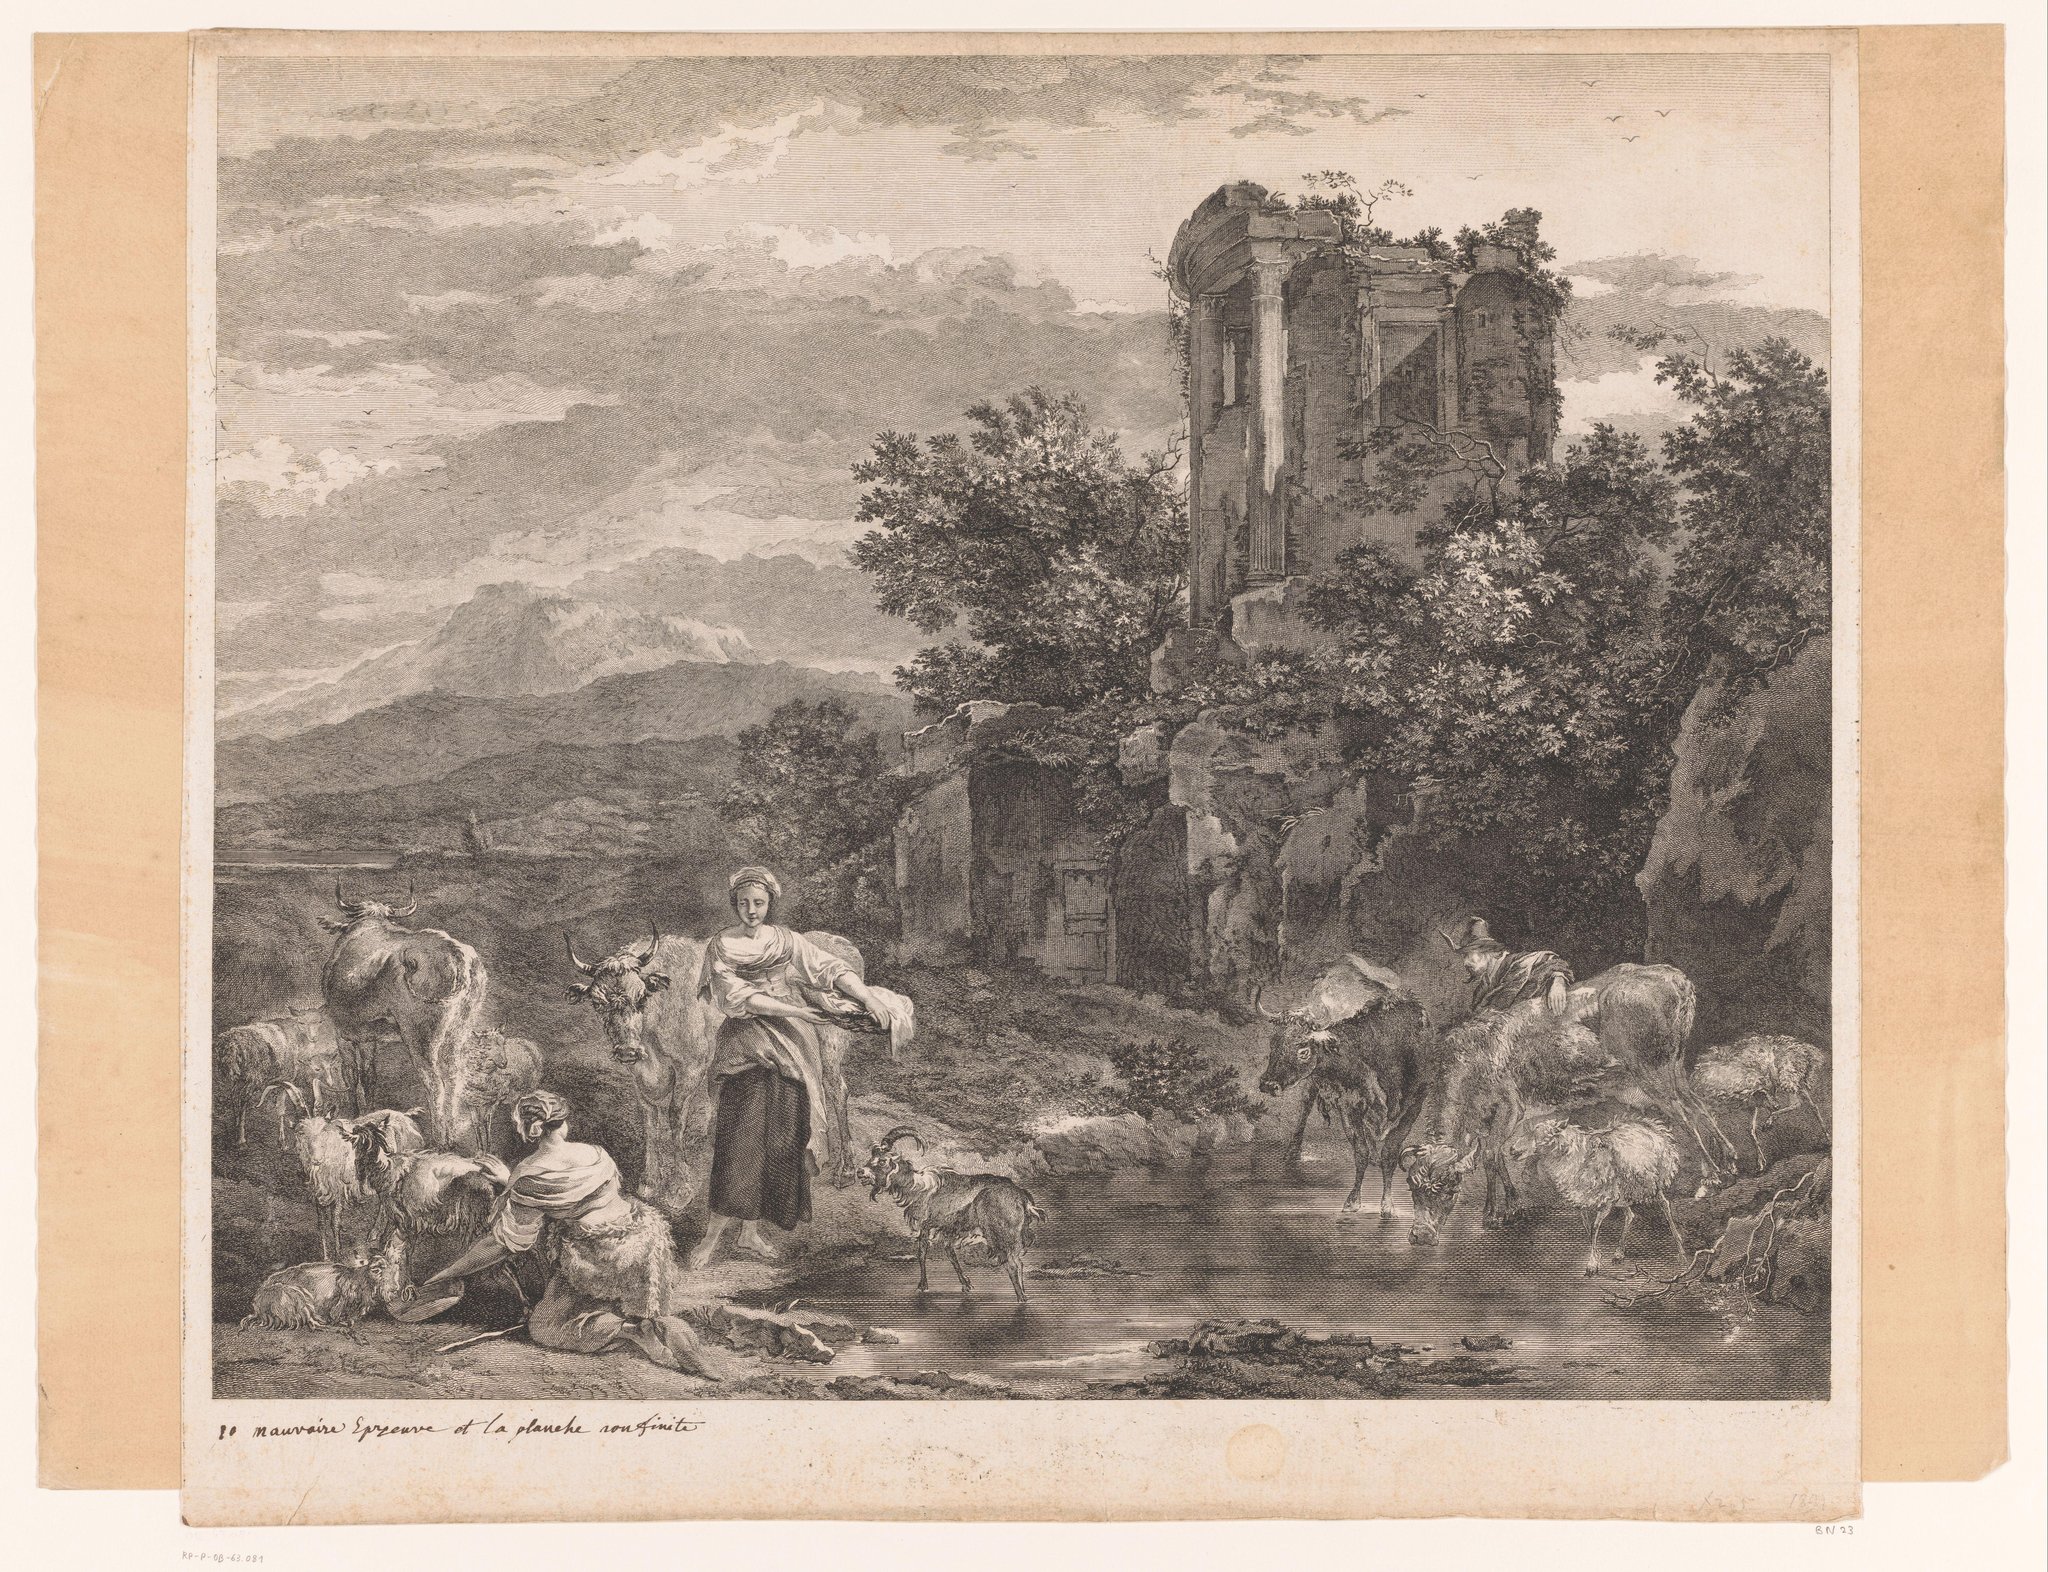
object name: print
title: Landschap met twee herderinnen en drinkend vee bij een ruïne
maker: pierre jacques duret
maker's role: print maker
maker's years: 1729-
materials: paper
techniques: engraving, etching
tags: landscape with ruins, herd, flock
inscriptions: collector's mark: Lugt 240, inscription: ‘80 [?] mauvaise Epreuve et la planche non finite’